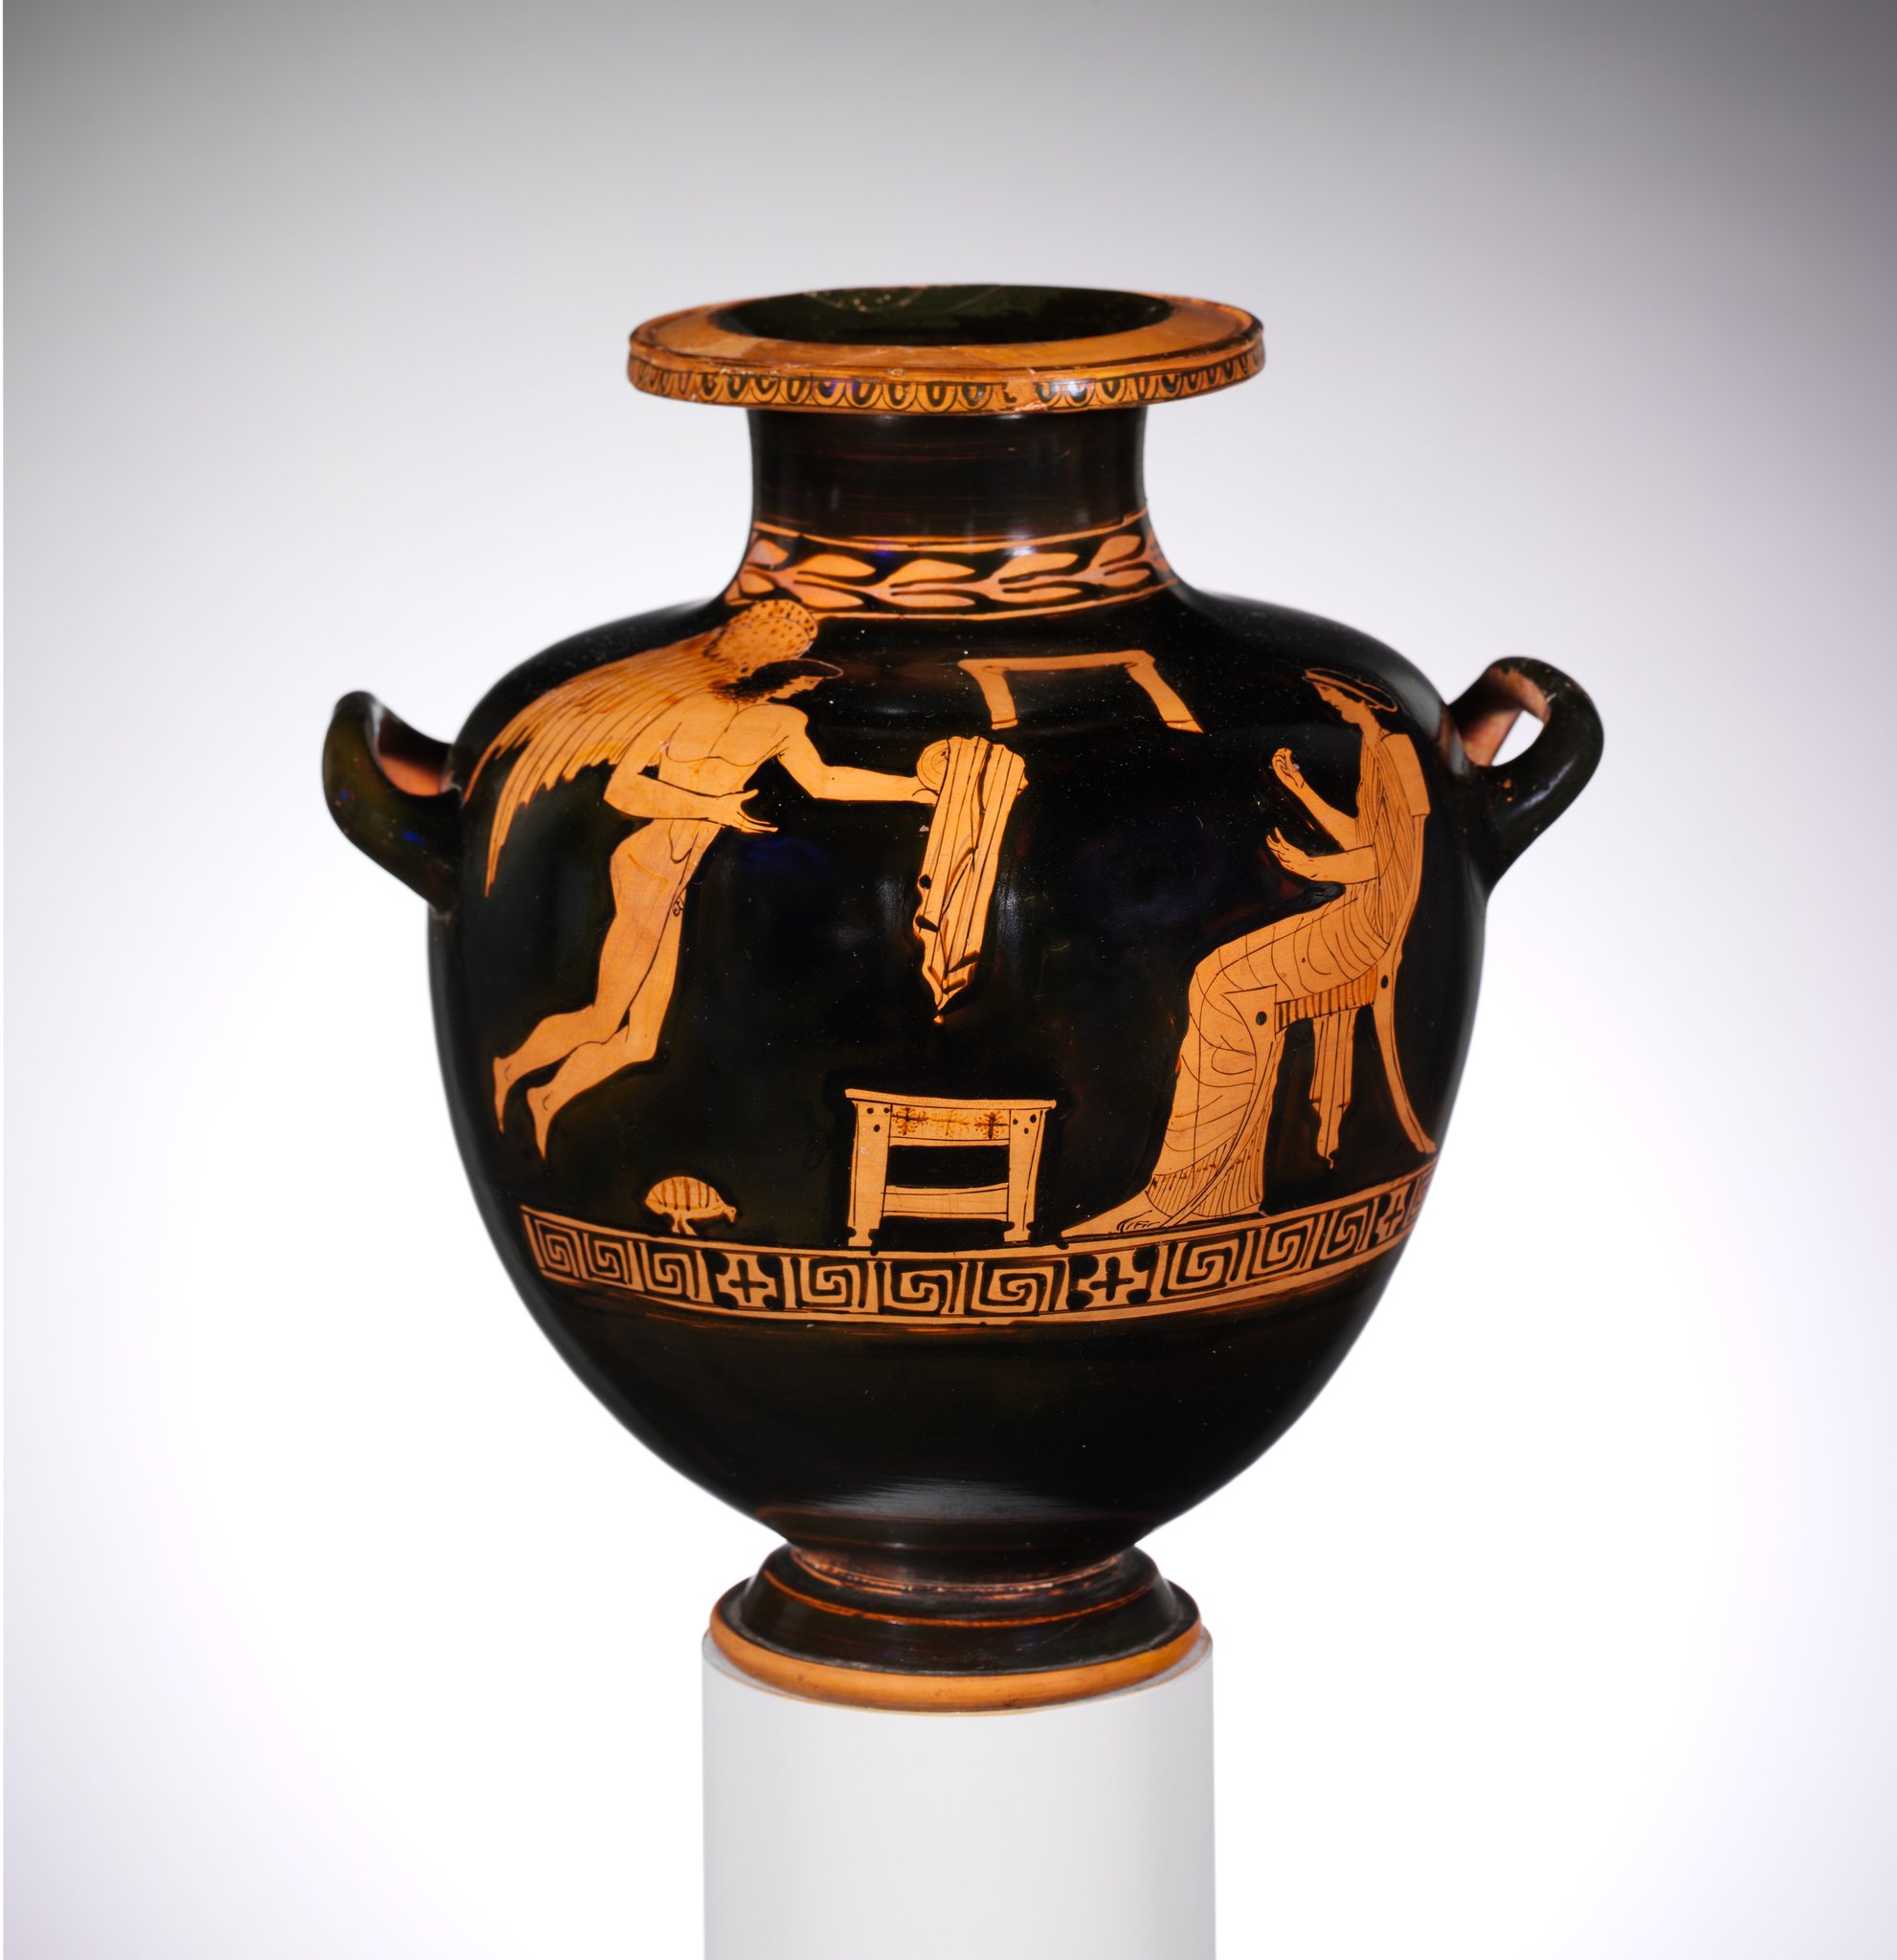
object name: hydria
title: Terracotta hydria (water jar)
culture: greek, attic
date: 430-420 BCE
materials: terracotta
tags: birds,women,eros